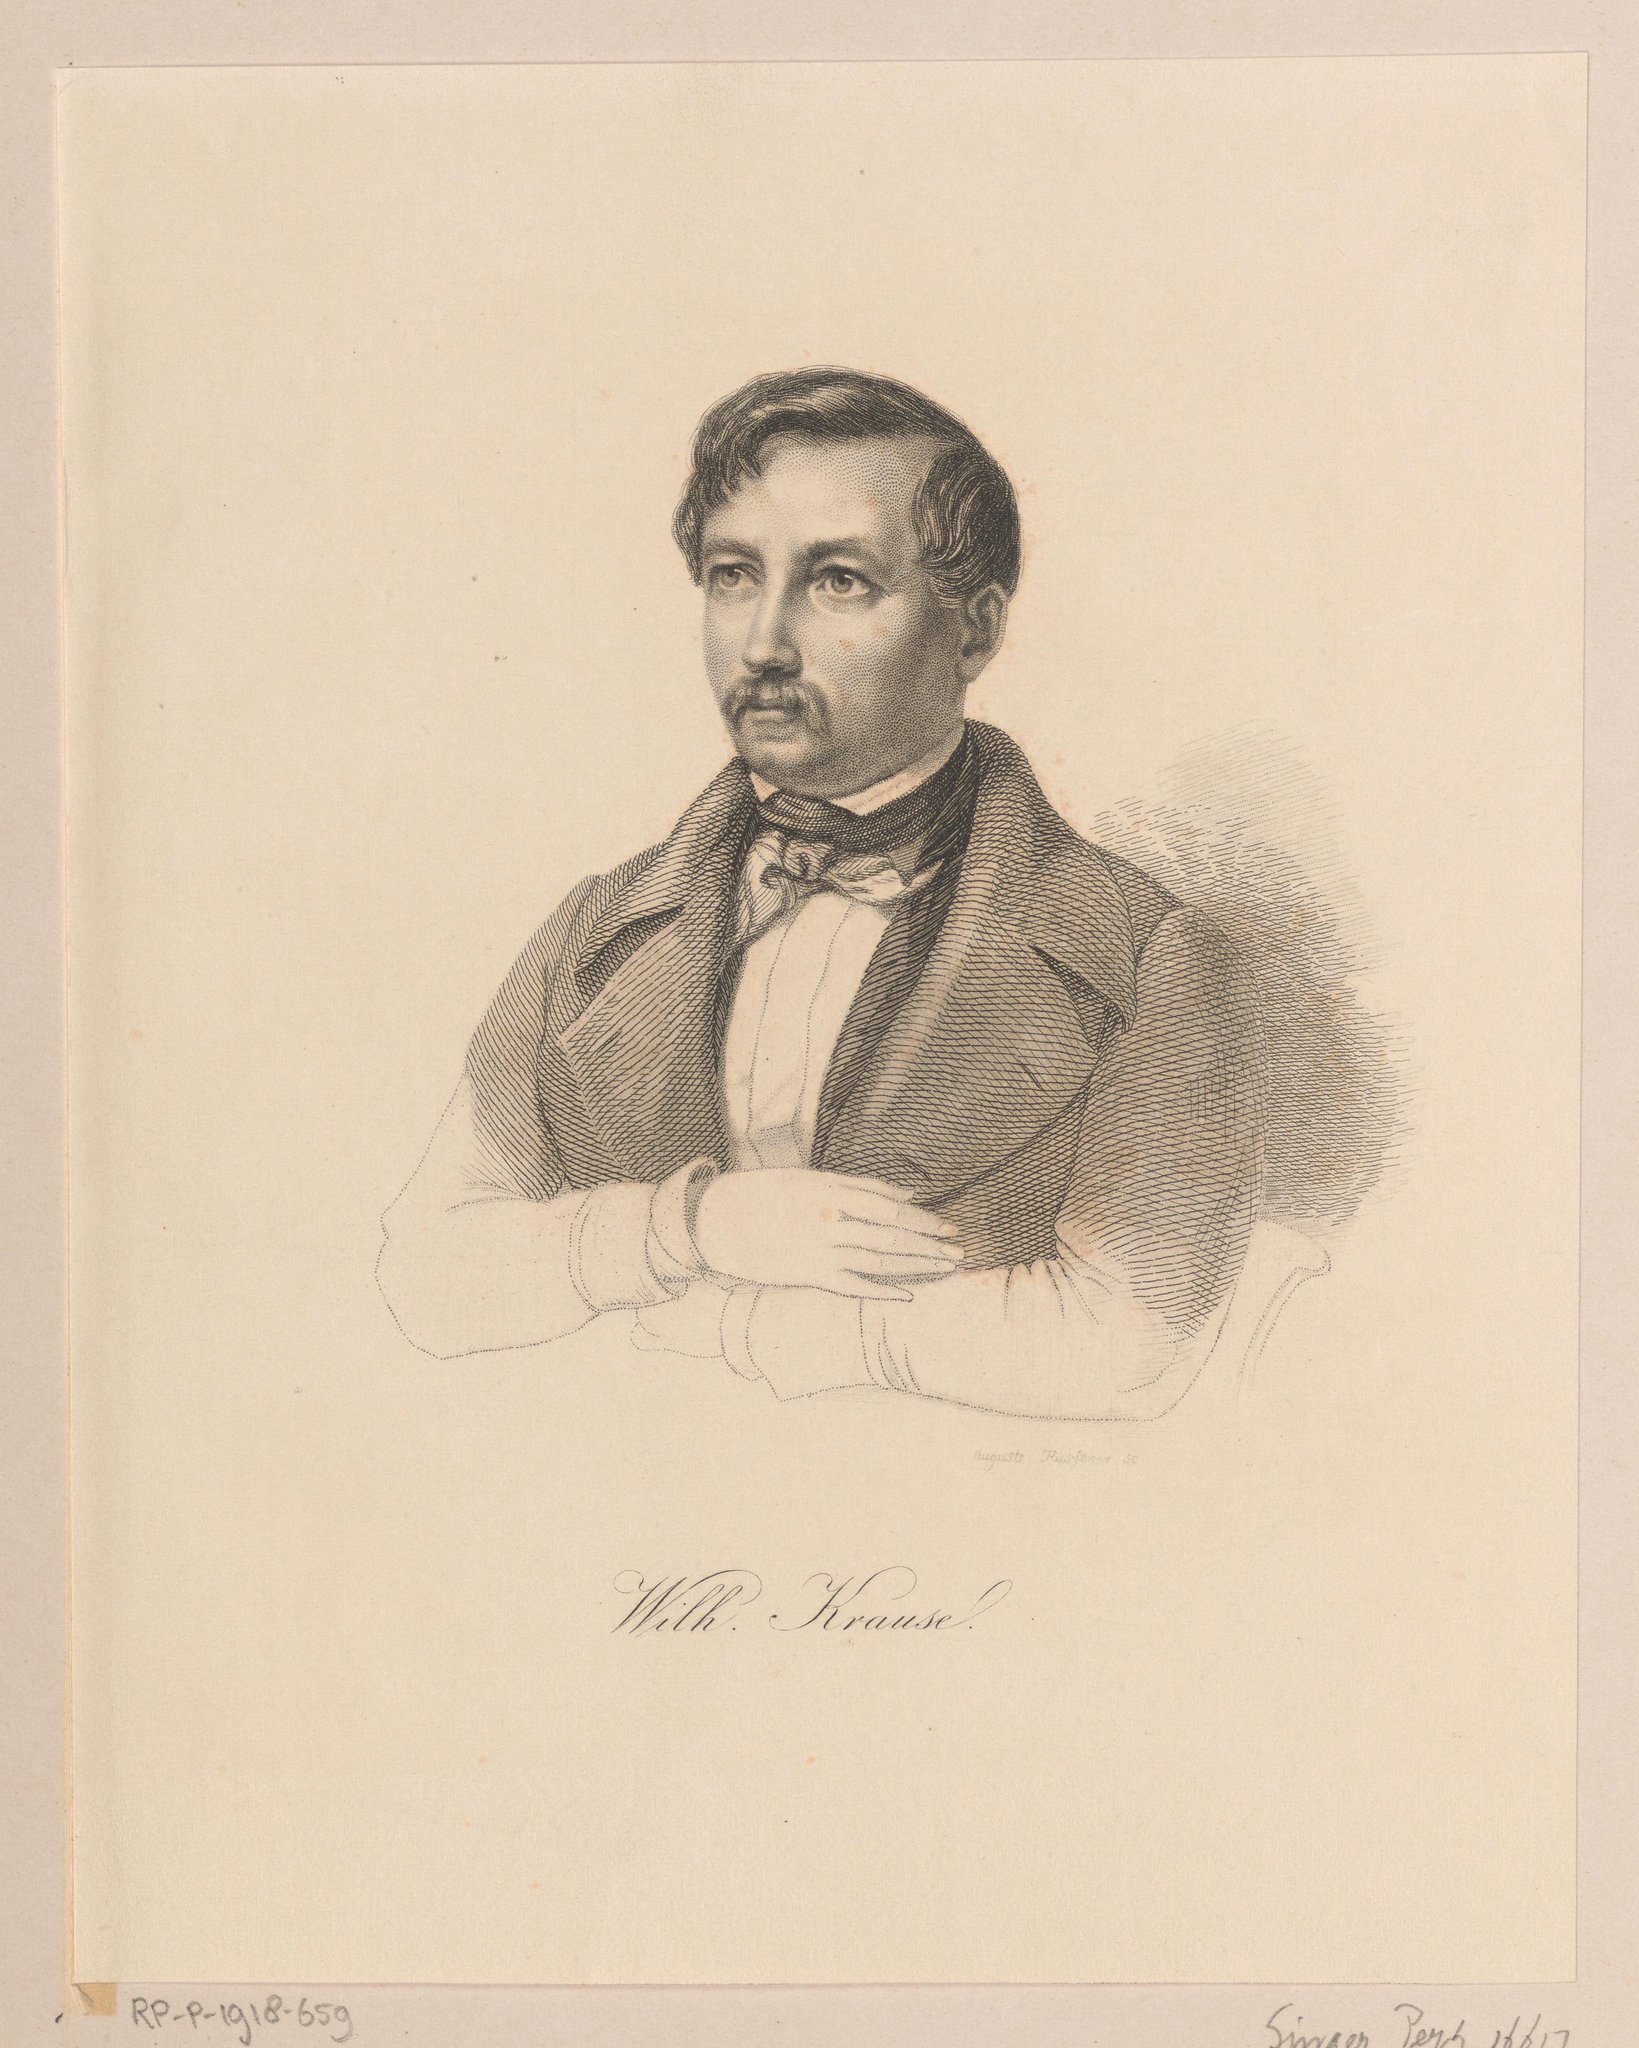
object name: print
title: Portret van Wilhelm Krause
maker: auguste hüssener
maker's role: print maker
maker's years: 1789-1877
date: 1818-1877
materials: paper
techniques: engraving, etching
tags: berlin, painter, historical persons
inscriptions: collector's mark: Lugt 2233